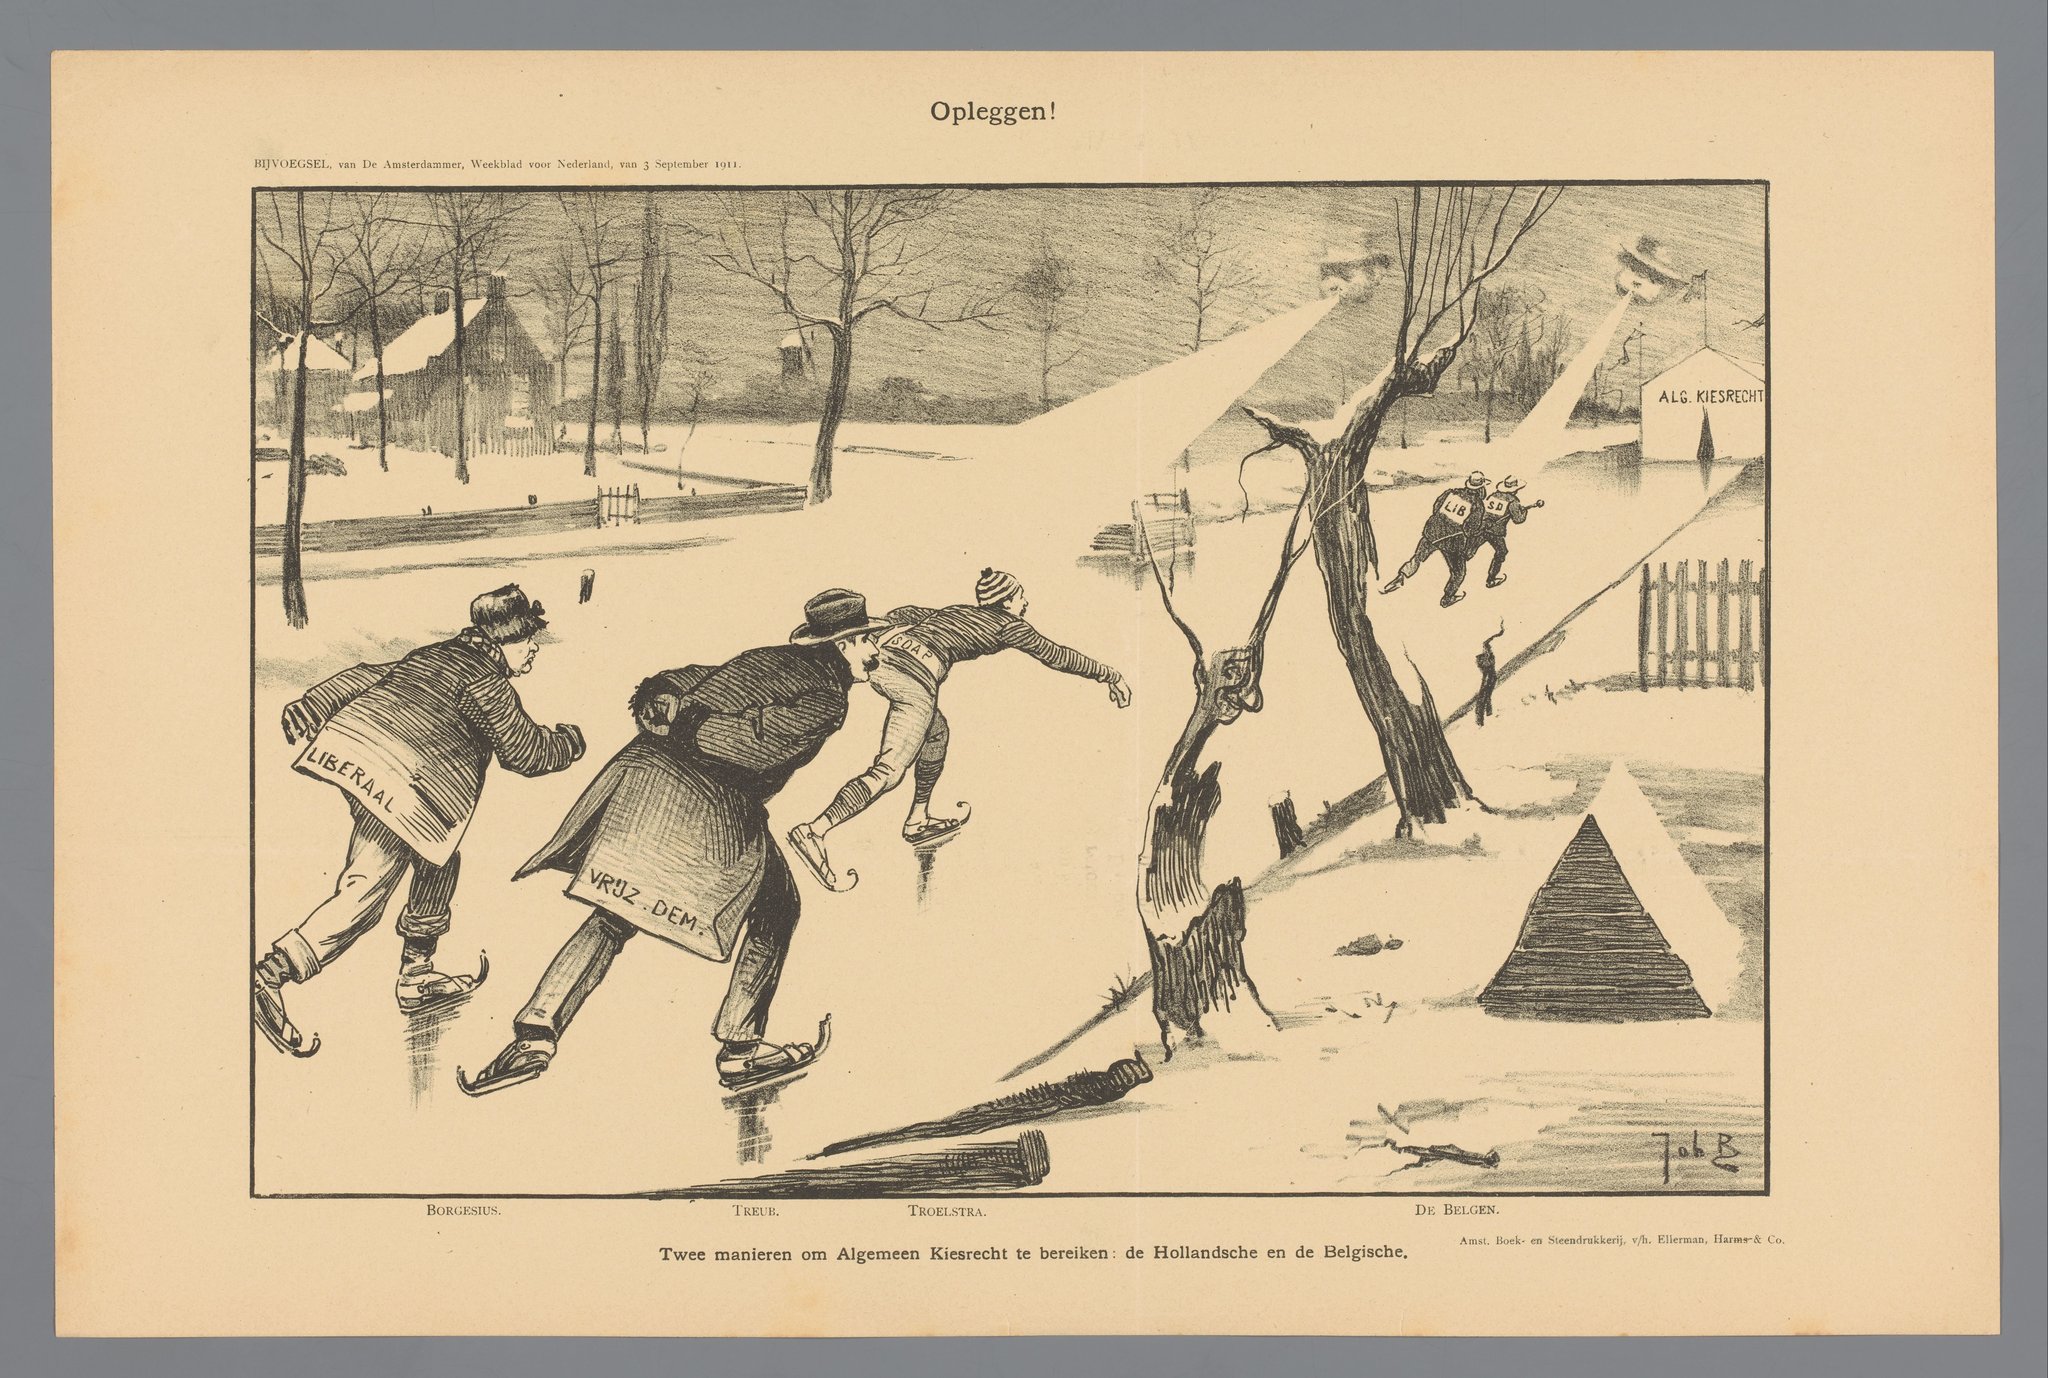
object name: cartoon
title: Opleggen!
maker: johan braakensiek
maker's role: draughtsman, print maker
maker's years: 1858-1940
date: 1911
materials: paper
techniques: lithograph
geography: amsterdam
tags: the hague, politician, voorschoten, historical persons, skates (winter sports), political caricatures and satires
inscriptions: date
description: Prent uit het bijvoegsel van: De Amsterdammer. Weekblad voor Nederland, 3 september 1911.